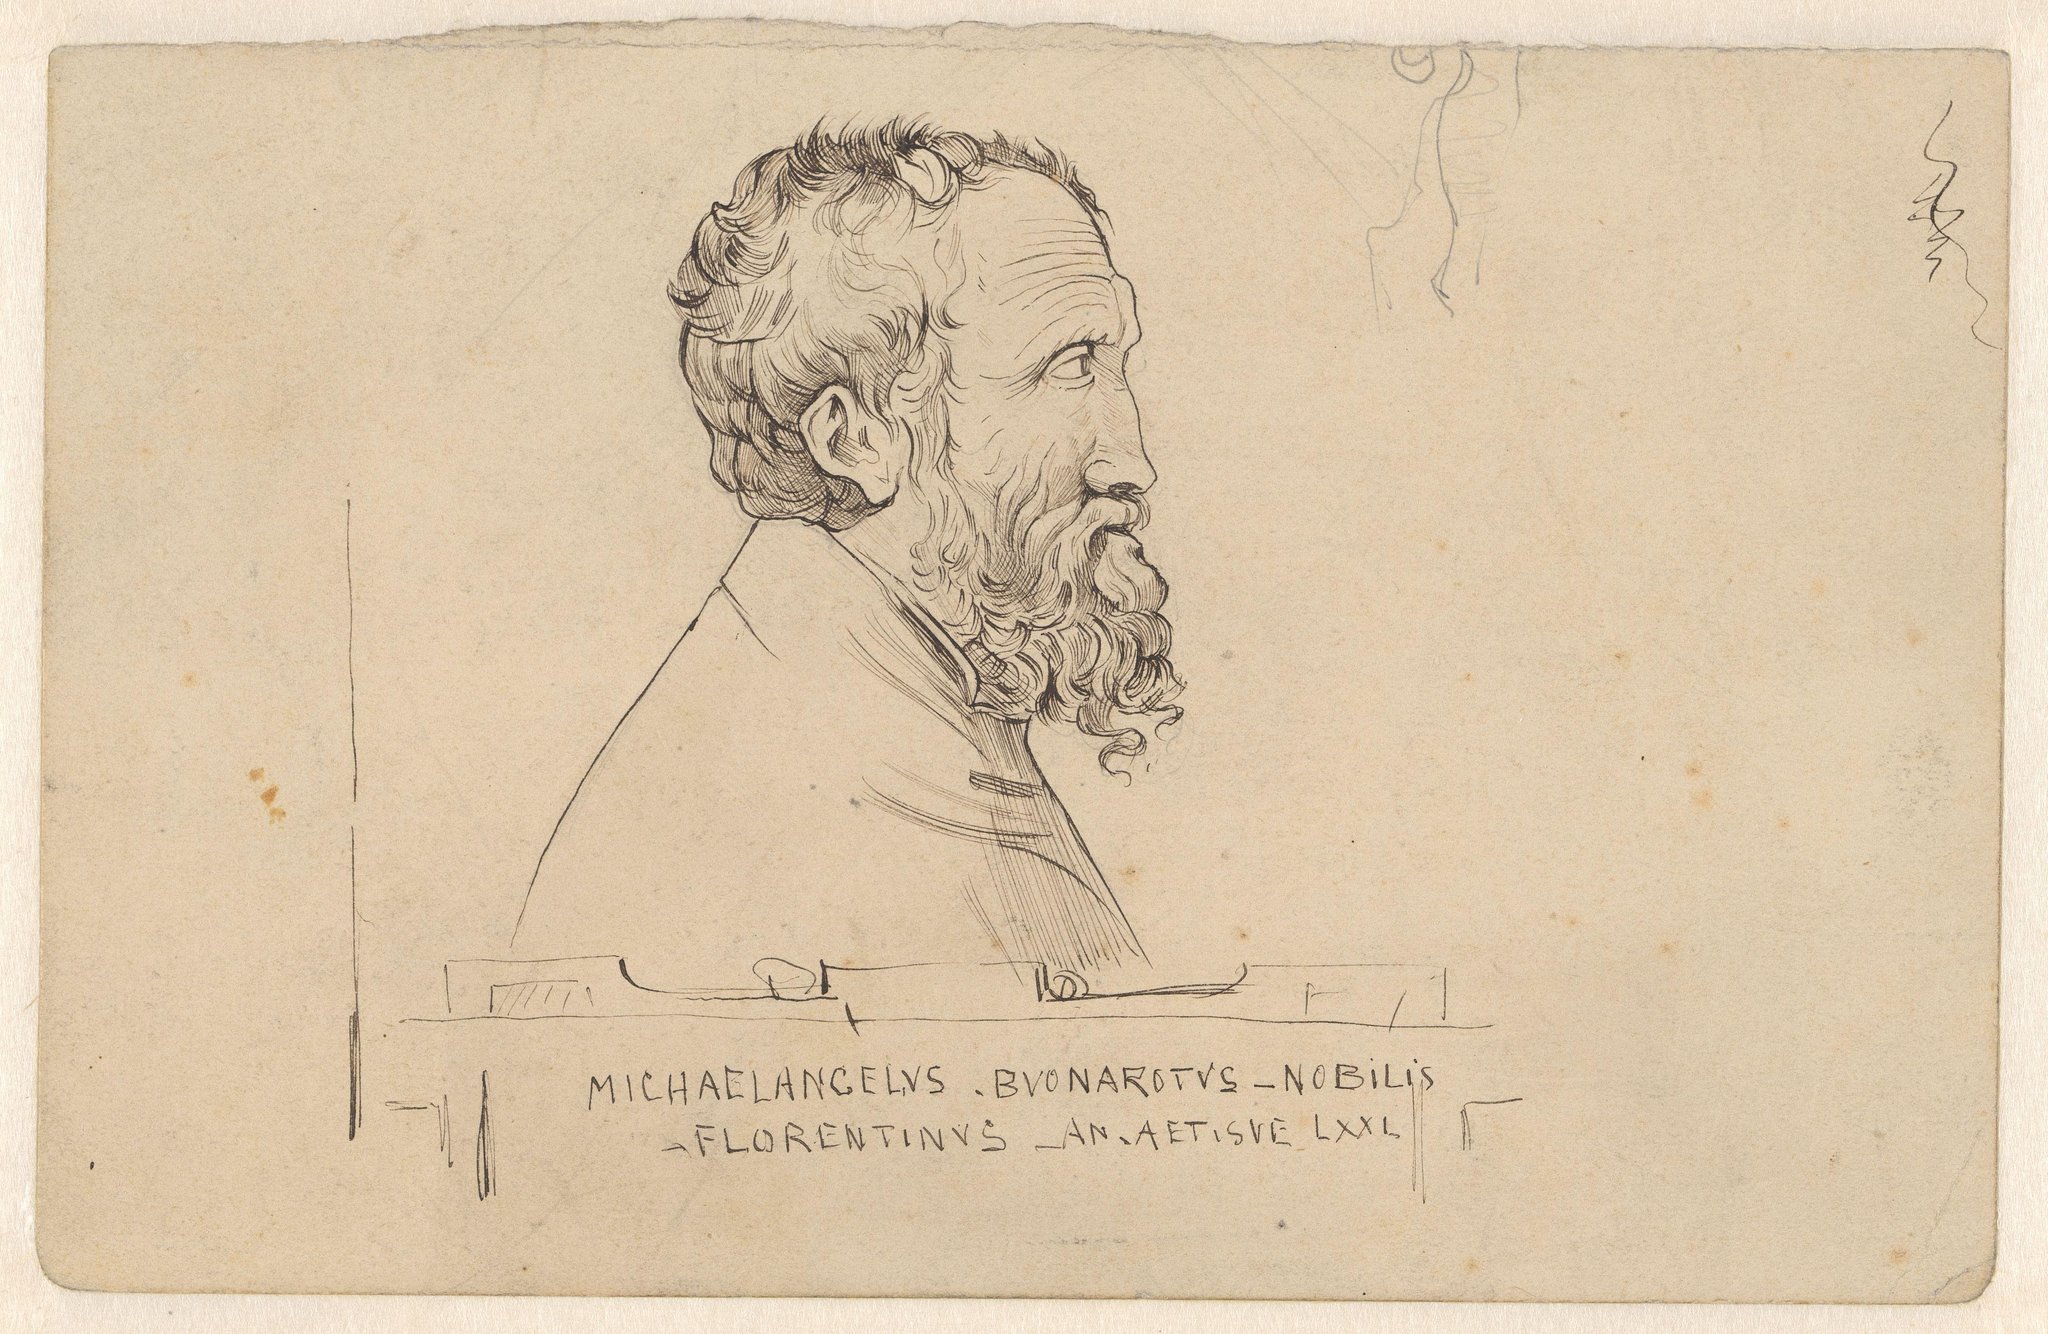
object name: drawing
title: Portret van Michelangelo op 71-jarige leeftijd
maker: nicolaas van der waay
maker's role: draughtsman, painter, print maker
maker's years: 1855-1936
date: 1884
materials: ink, paper, pencil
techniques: pen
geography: italy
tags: rome, painter, draughtsman, sculptor, michelangelo, portrait, self-portrait of artist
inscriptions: collector's mark: Lugt 2760, annotation: ‘[...]136/30’, collector's mark: Lugt 2228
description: Portret van Michelangelo met onderschrift: MICHAELANGELUS BUONAROTUS NOBILIS / FLORENTINUS - AN. AET. SUE LXXI.